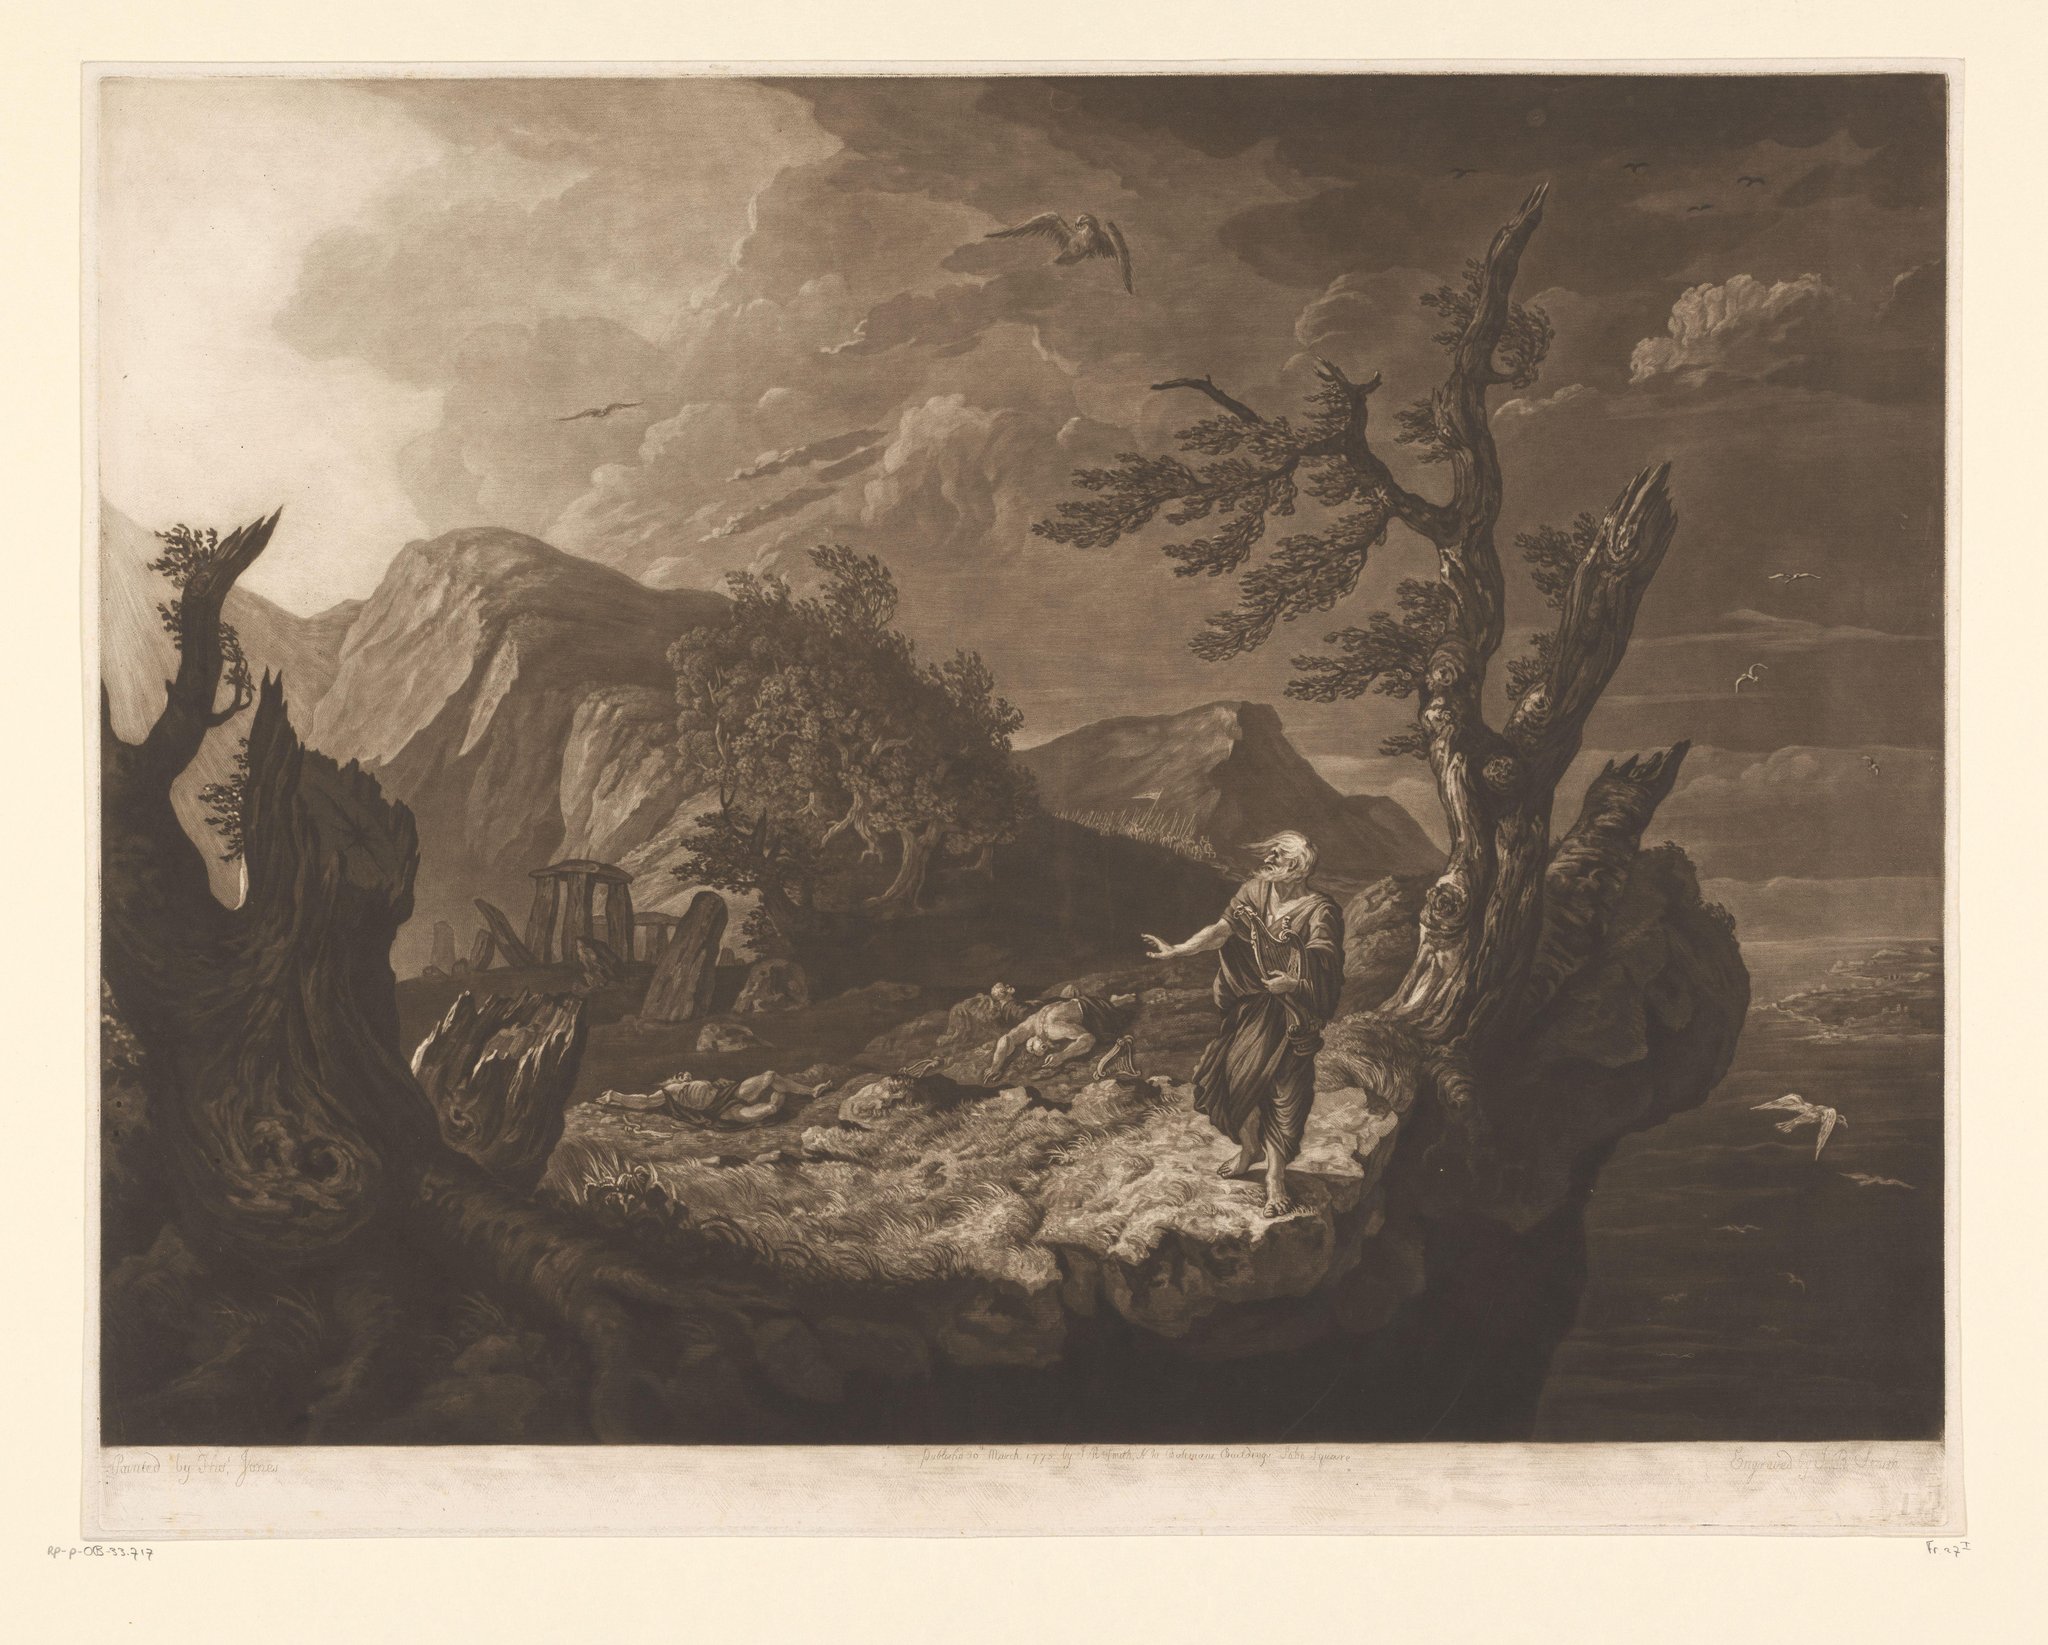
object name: print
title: Stormachtig landschap met bard aan de rand van een klif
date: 1703-1775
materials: paper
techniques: mezzotint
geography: london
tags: army 'en route', storm, coastal cliff or crag, bard, lyric poet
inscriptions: collector's mark: Lugt 240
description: De bard staat op het punt van de klif te springen en kijkt achterom naar het naderende leger van Eduard I. Illustratie bij het gedicht 'The Bard' van Thomas Gray.